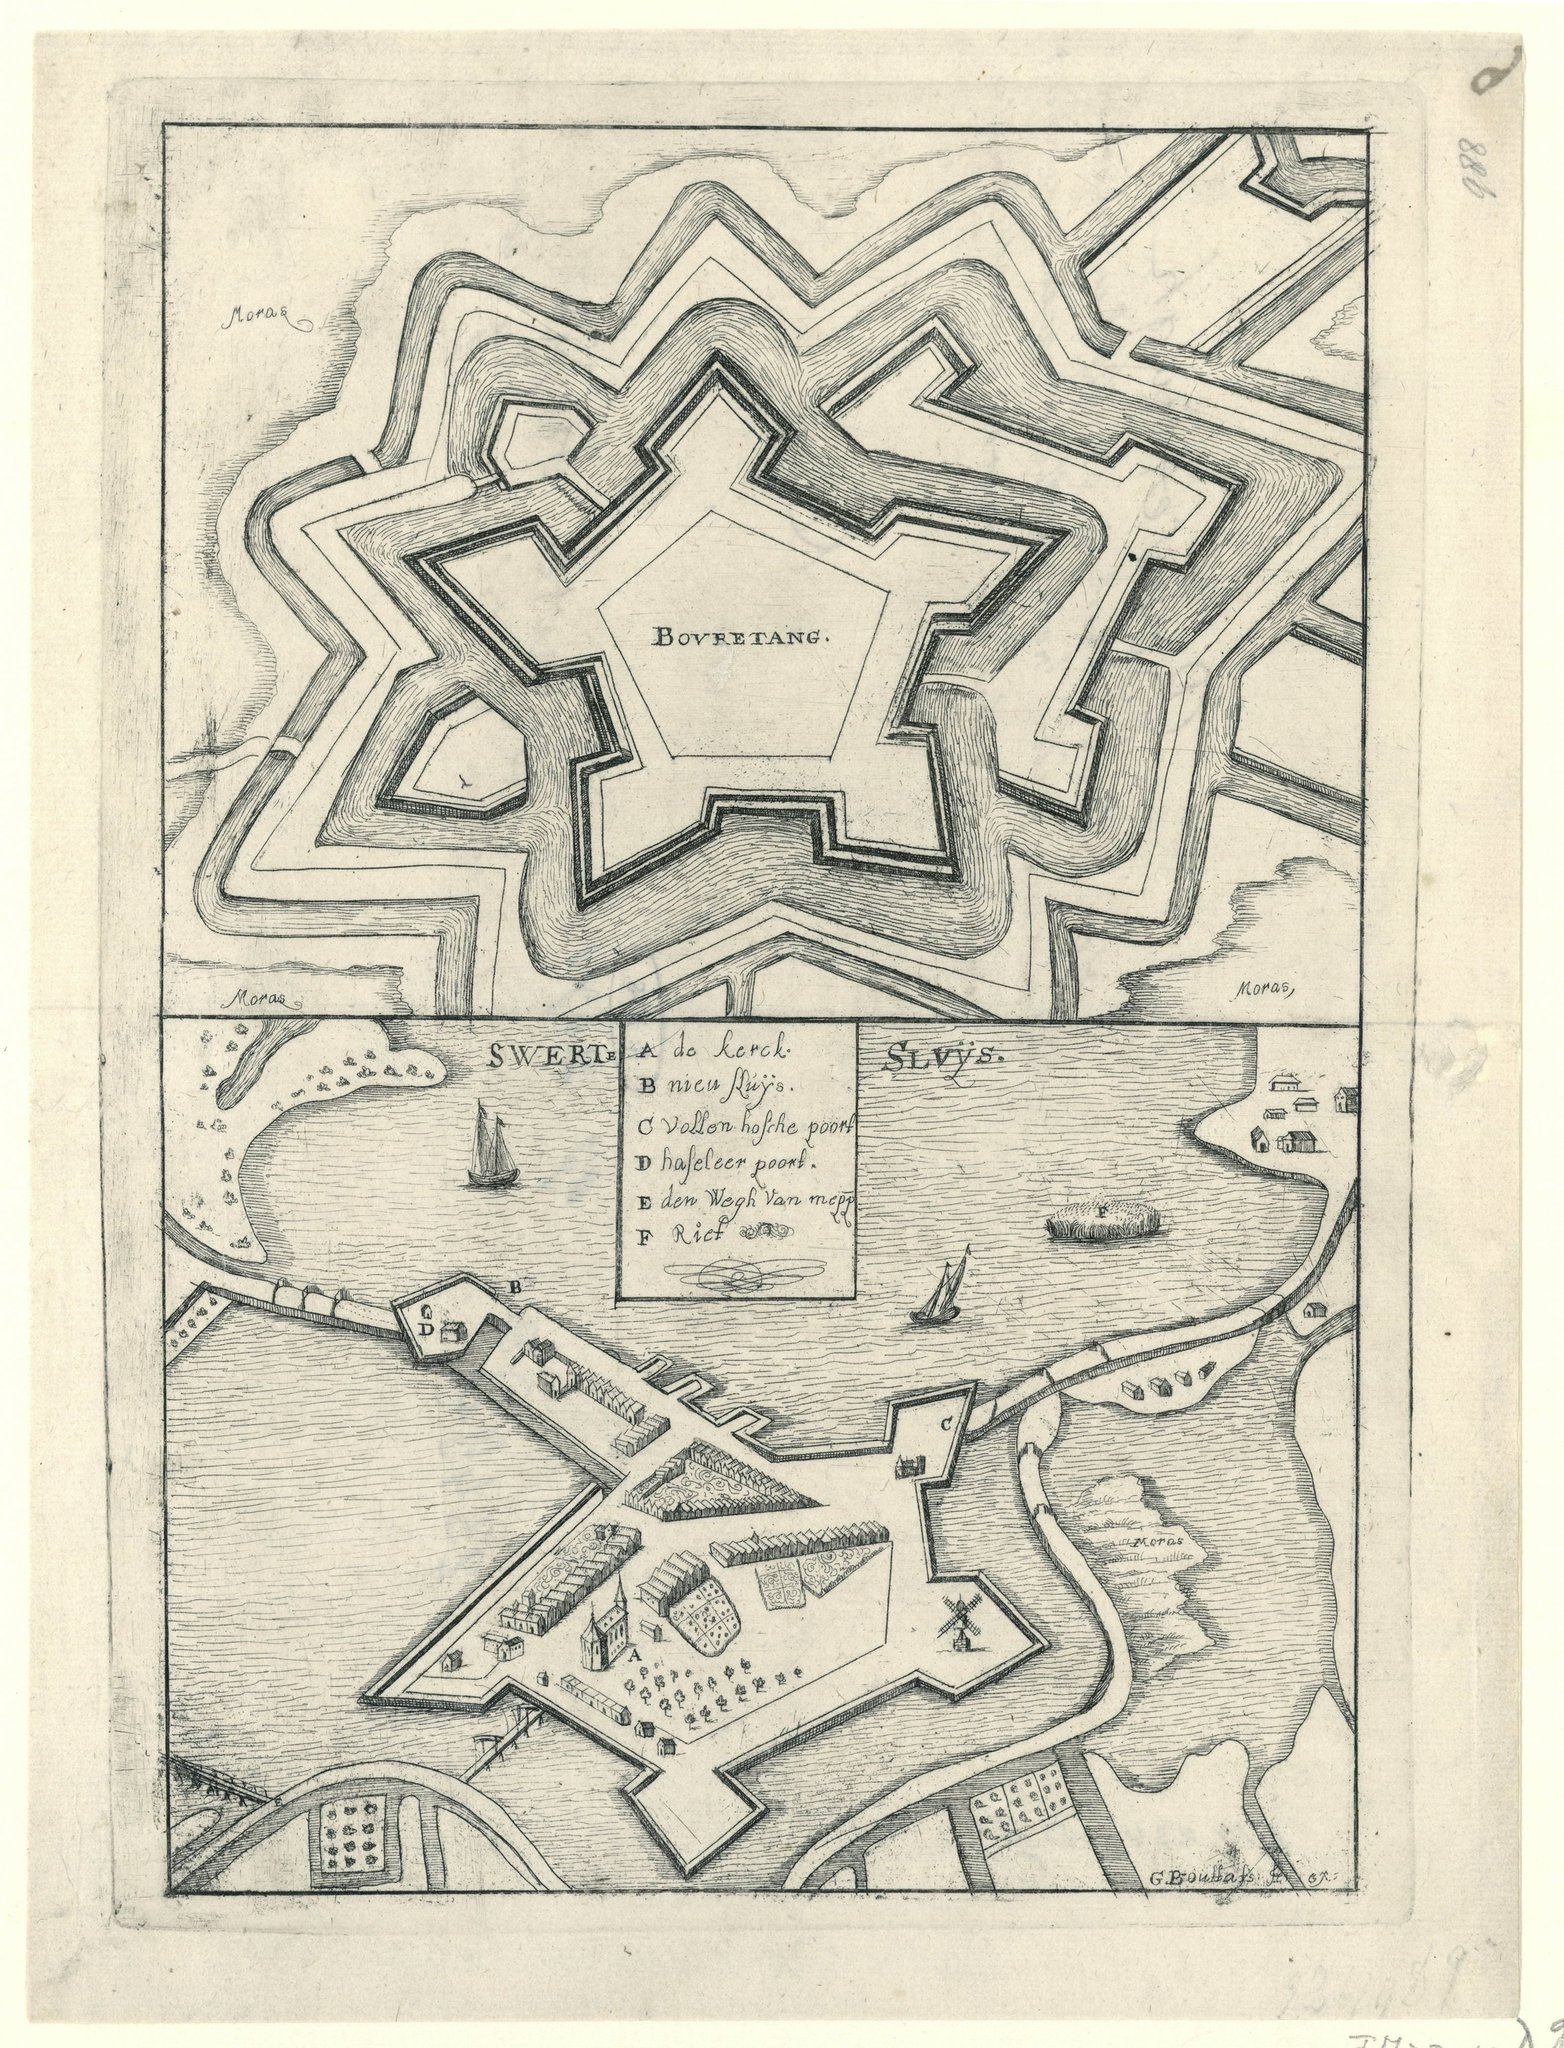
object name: print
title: Plattegronden van de vestingen te Boertange en Zwartsluis, veroverd door de Fransen of Munstersen, 1672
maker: gaspar bouttats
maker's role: print maker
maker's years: 1640-1695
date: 1672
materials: paper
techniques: etching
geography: antwerp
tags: maps of cities, rampjaar (disaster year)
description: Plattegronden van de vestingen te Boertange en Zwartsluis. Deze prent maakt deel uit van een groep van twaalf prenten, merendeels geëetst en uitgegeven door Gaspar Bouttats, met gezichten op vestingen en steden veroverd door de Fransen en de bisschop van Munster in 1672.